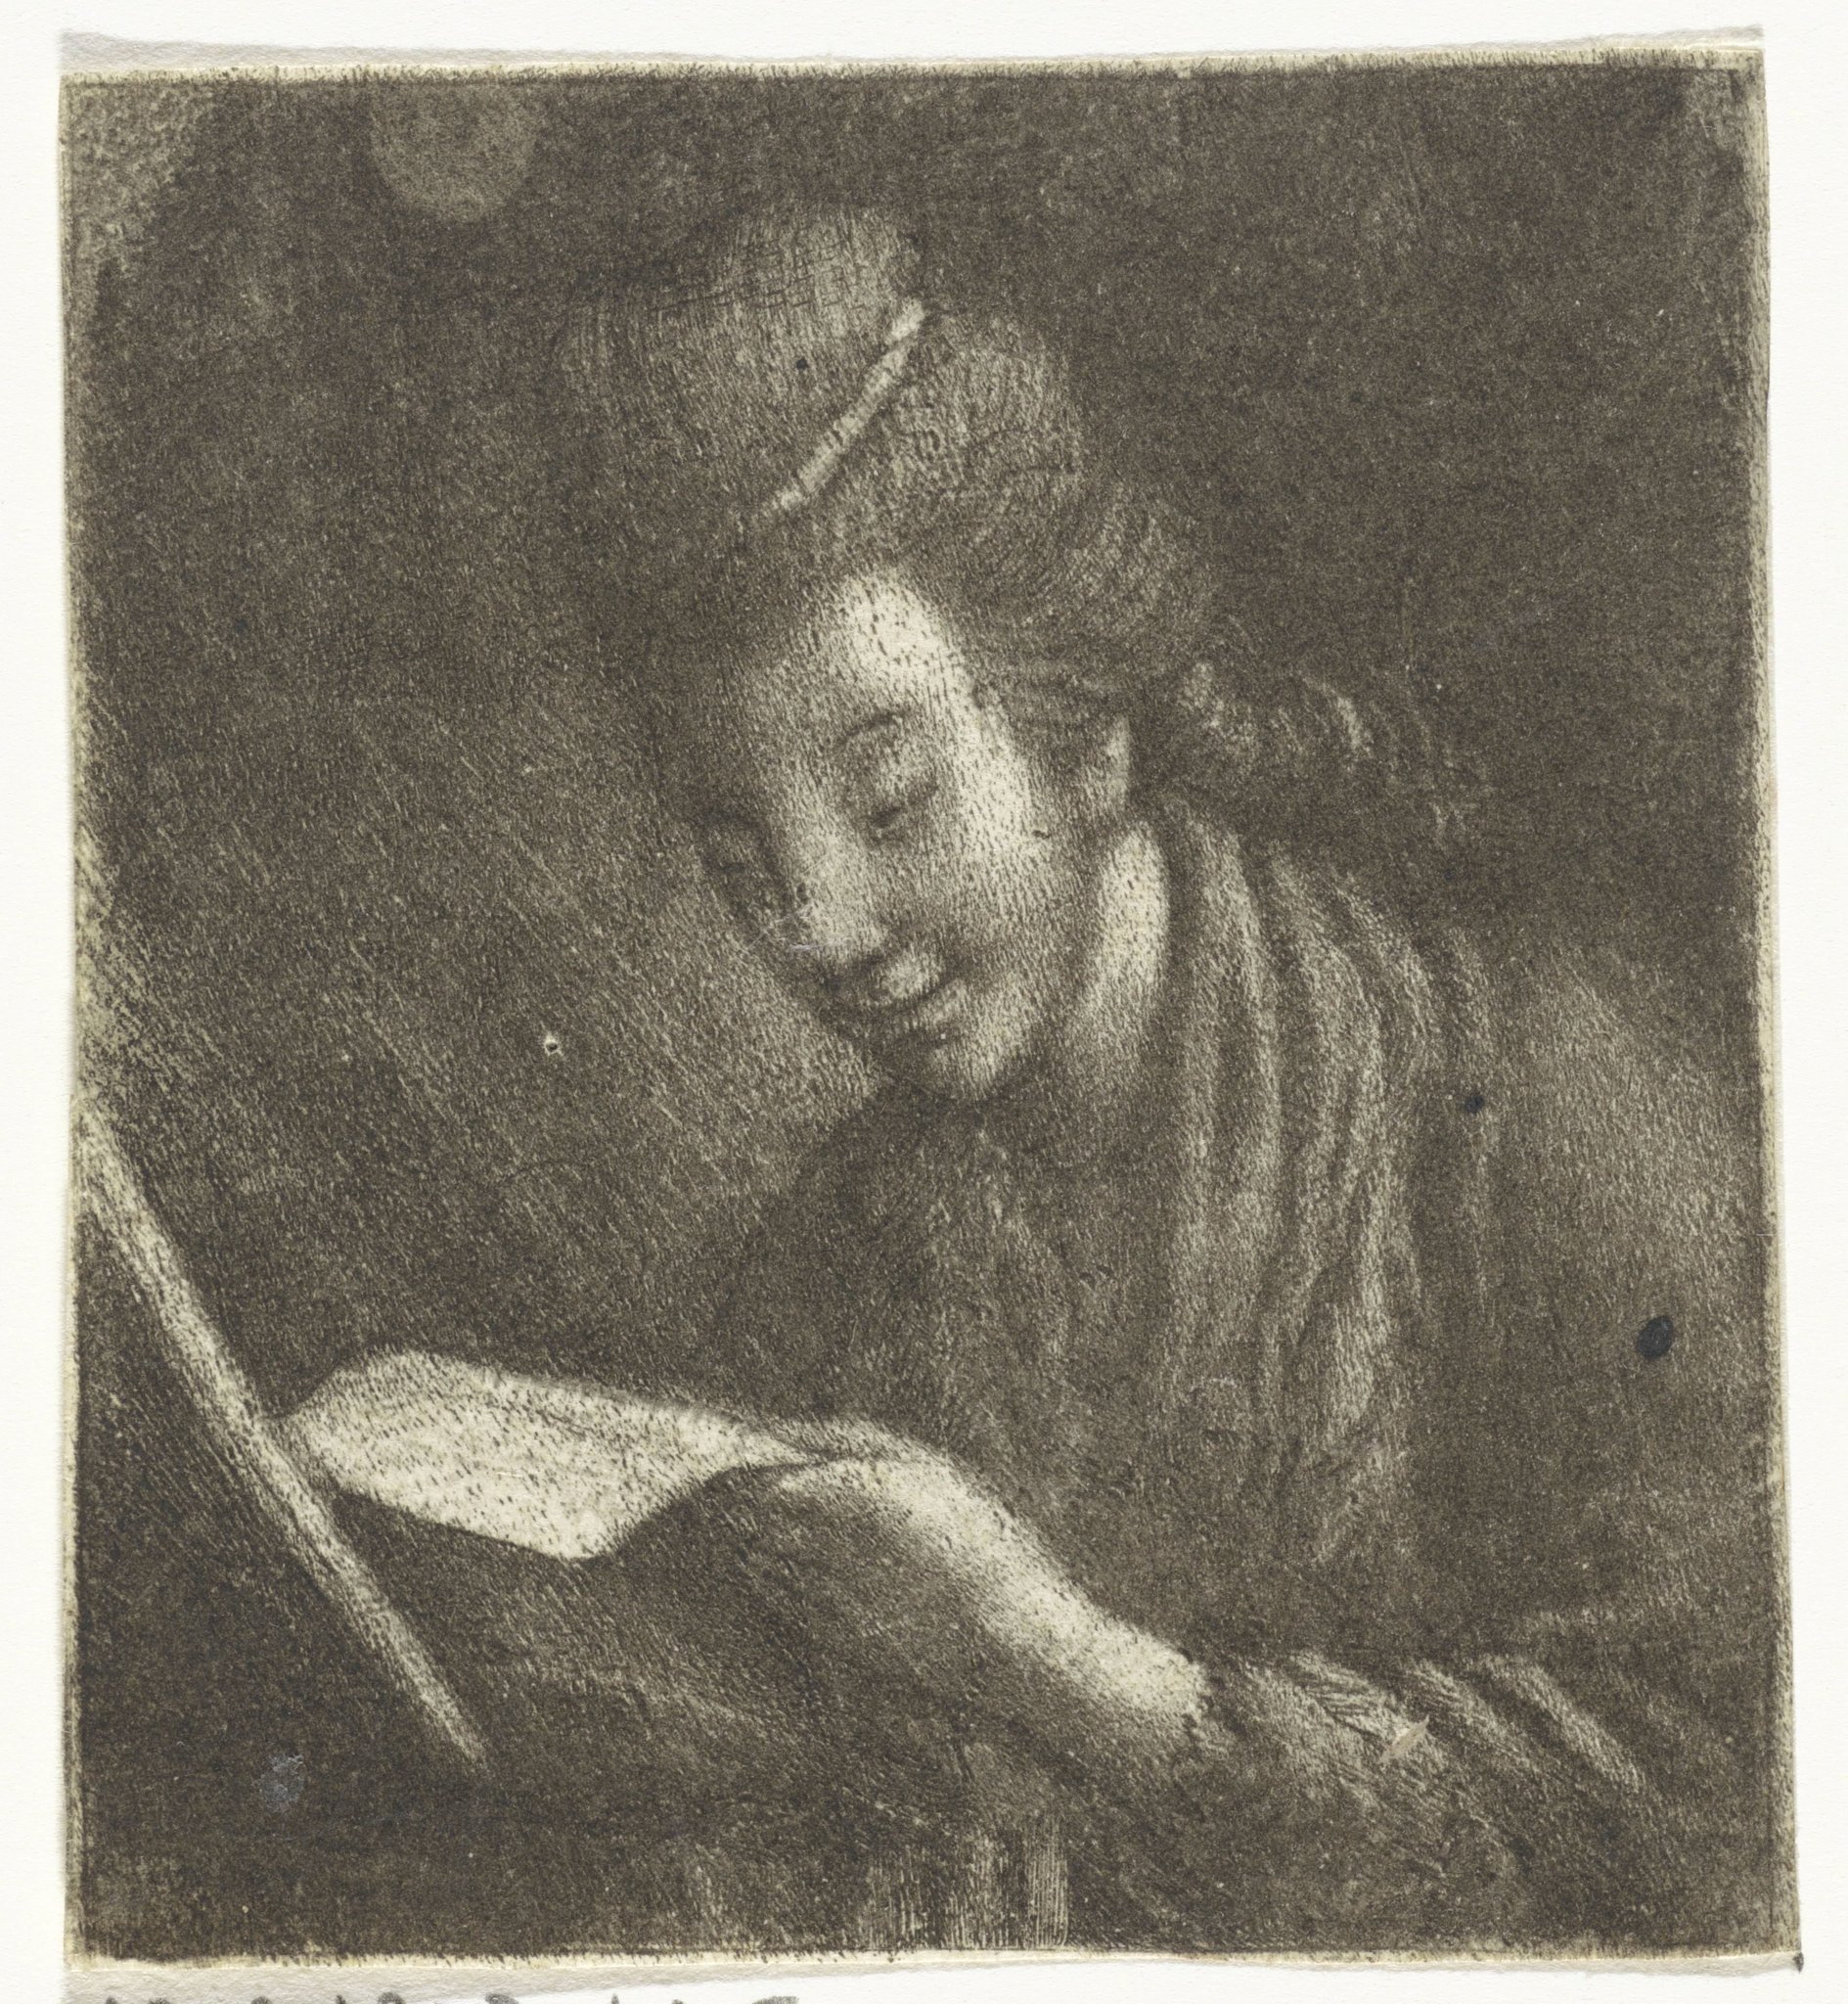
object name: print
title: Jonge vrouw met bladmuziek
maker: theodorus de roode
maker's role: draughtsman, print maker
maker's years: 1736-1793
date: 1746-1793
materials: paper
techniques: mezzotint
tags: reading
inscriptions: collector's mark: Lugt 2228